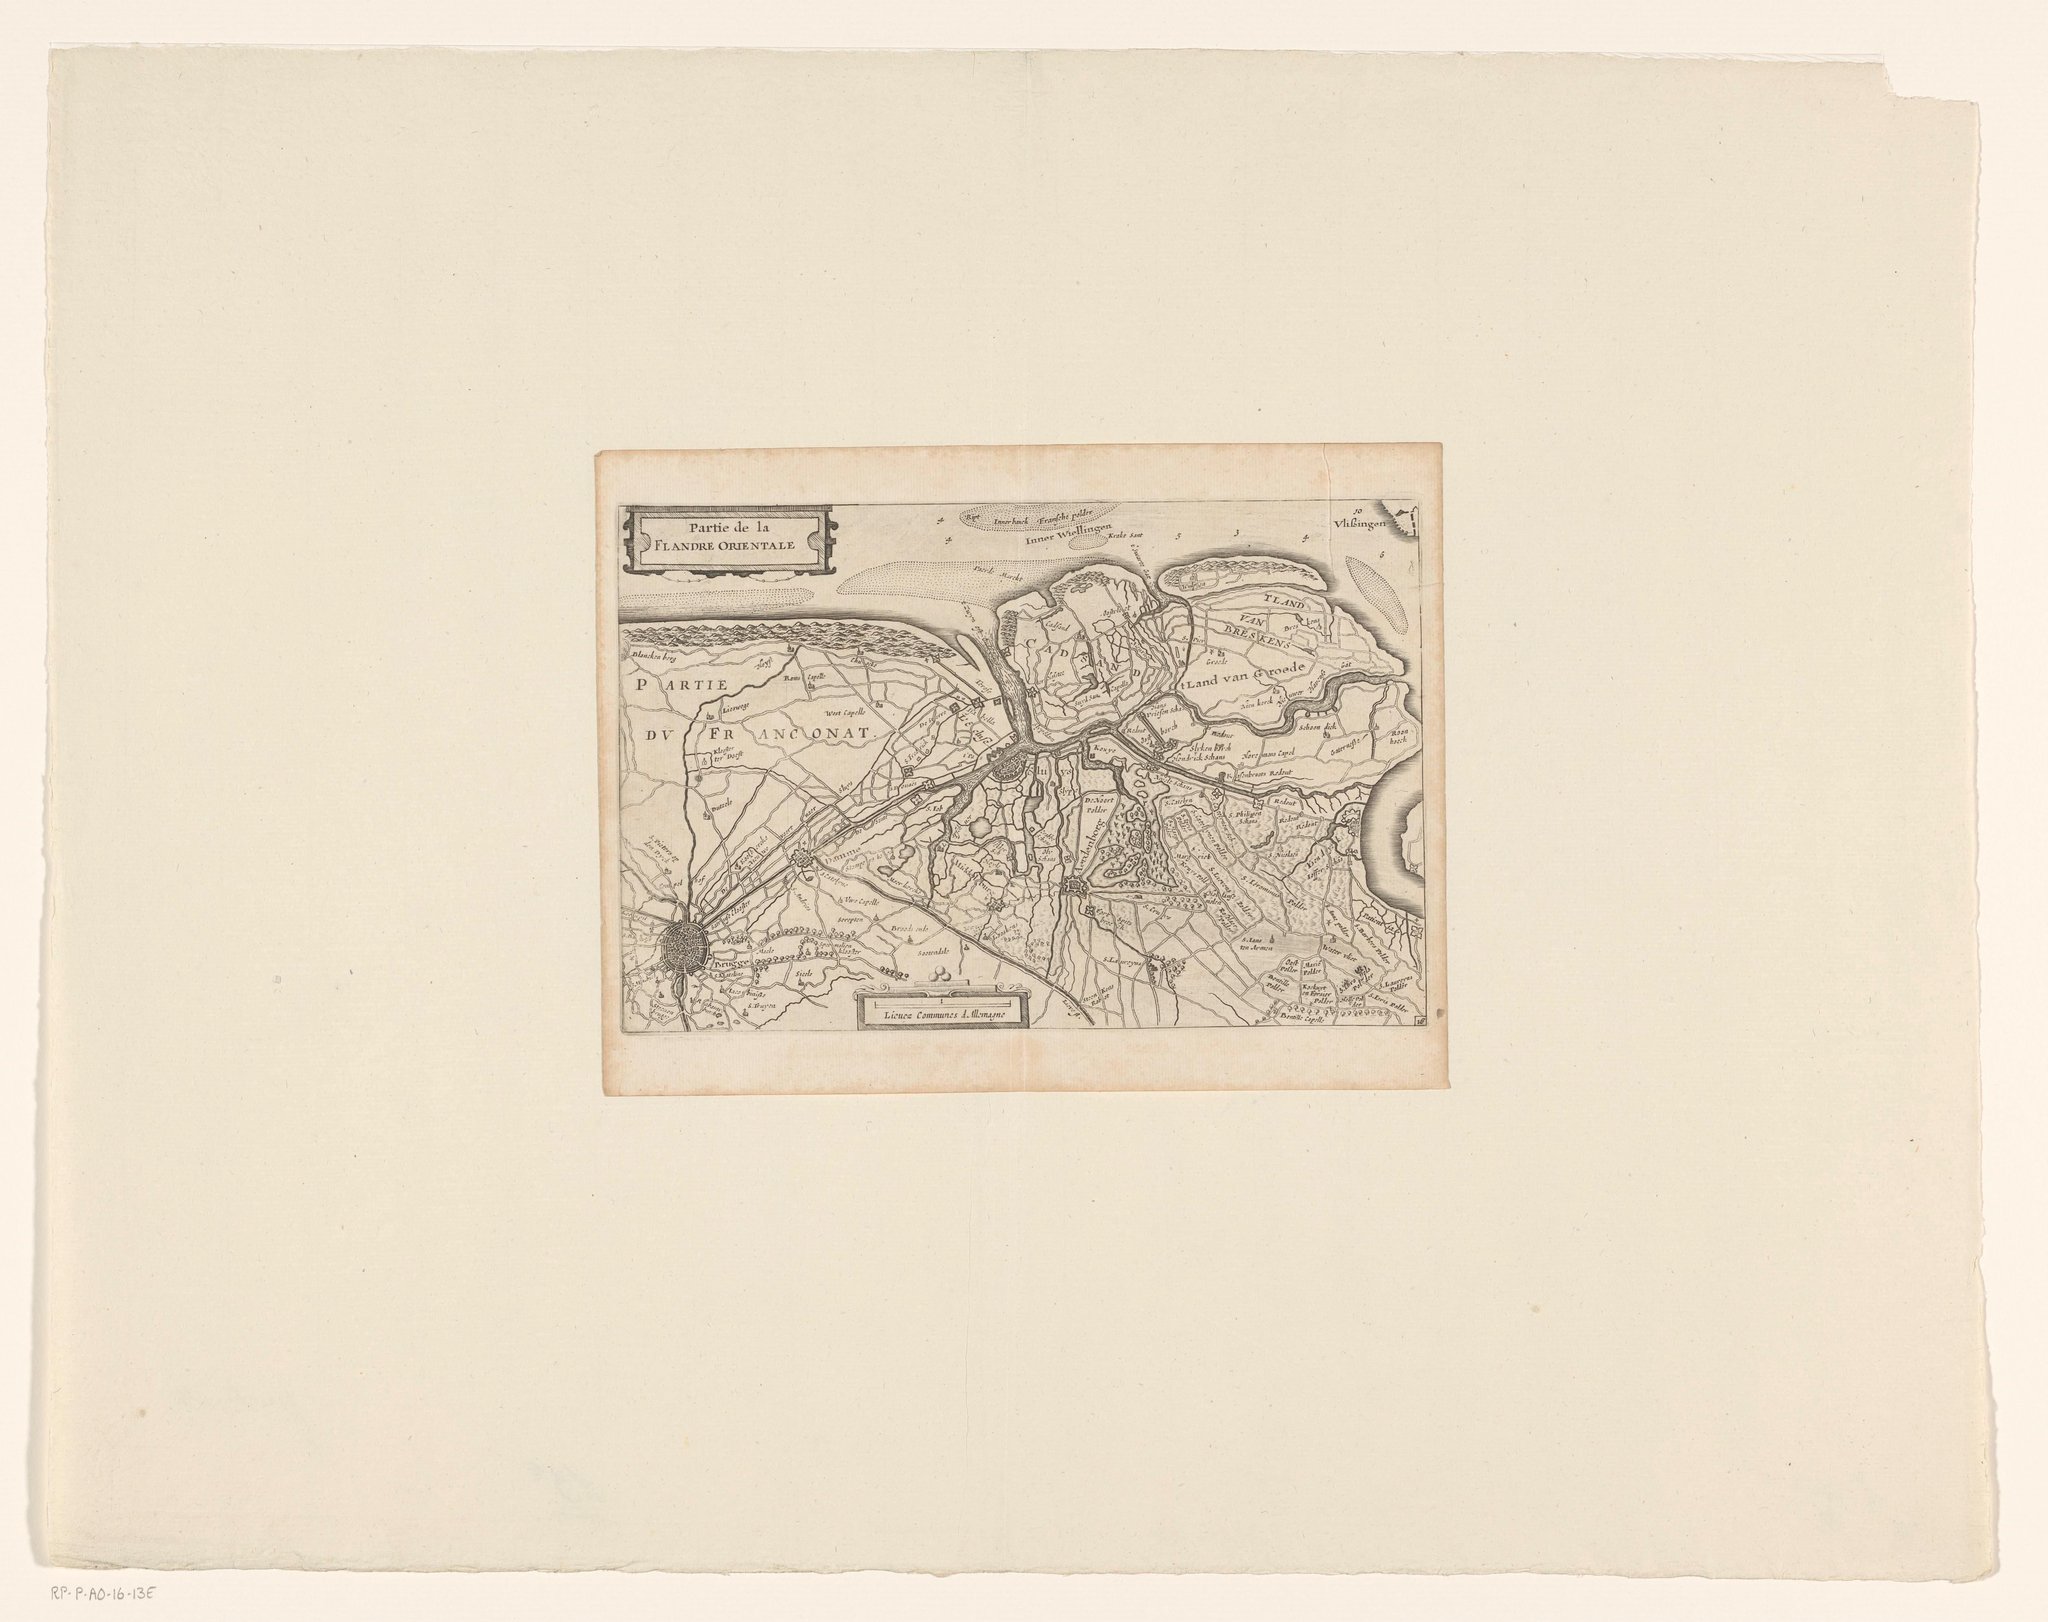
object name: map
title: Partie de la Flandre Orientale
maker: Anonymous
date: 1635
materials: paper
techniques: engraving, etching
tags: maps of separate countries or regions, bruges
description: Deze staat van prent ook gebruikt in: De vyerighe colom klaer vertoonende in vyftich onderscheydene curieuse caarten de XVII. Nederlantsche Provincien (…). Amsterdam: Jacob Aertsz Colom (I), s.a. [ca. 1660]. En in latere uitgaven met de platen van deze publicatie, uitgegeven door Pieter van Alphen (1691) en Pieter van der Slaart (1696). Eerdere staat van prent (zonder '16' rechtsonder) ook gebruikt in eerdere drukken van deze publicatie.